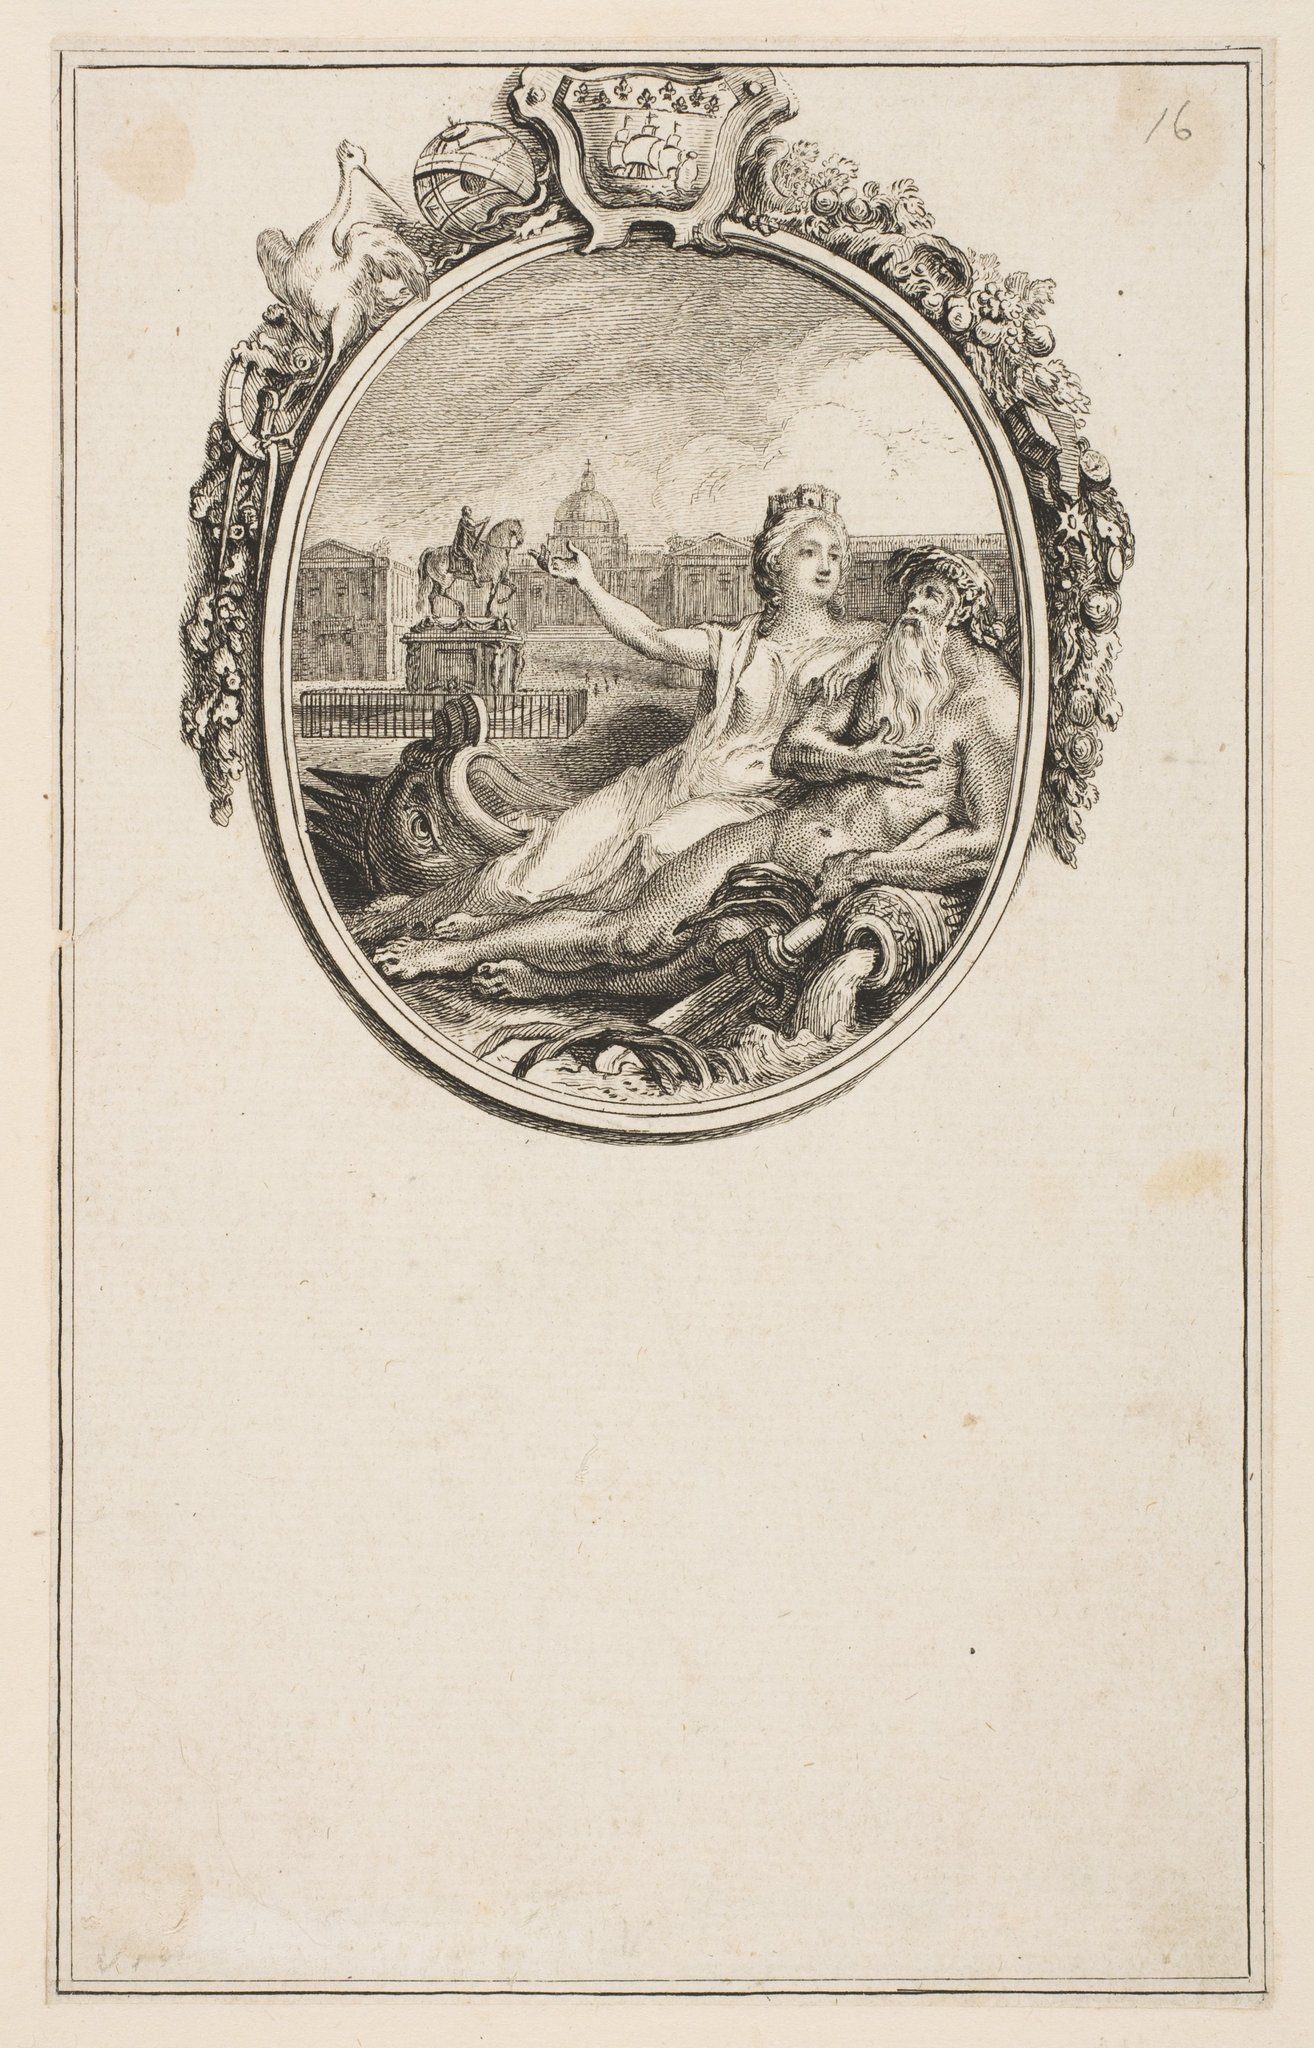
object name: print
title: Inauguration de la statue equestre de Louis XV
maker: gabriel de saint-aubin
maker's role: artist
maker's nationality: french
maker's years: 1724-1780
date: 1766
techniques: etching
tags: men,women,horses